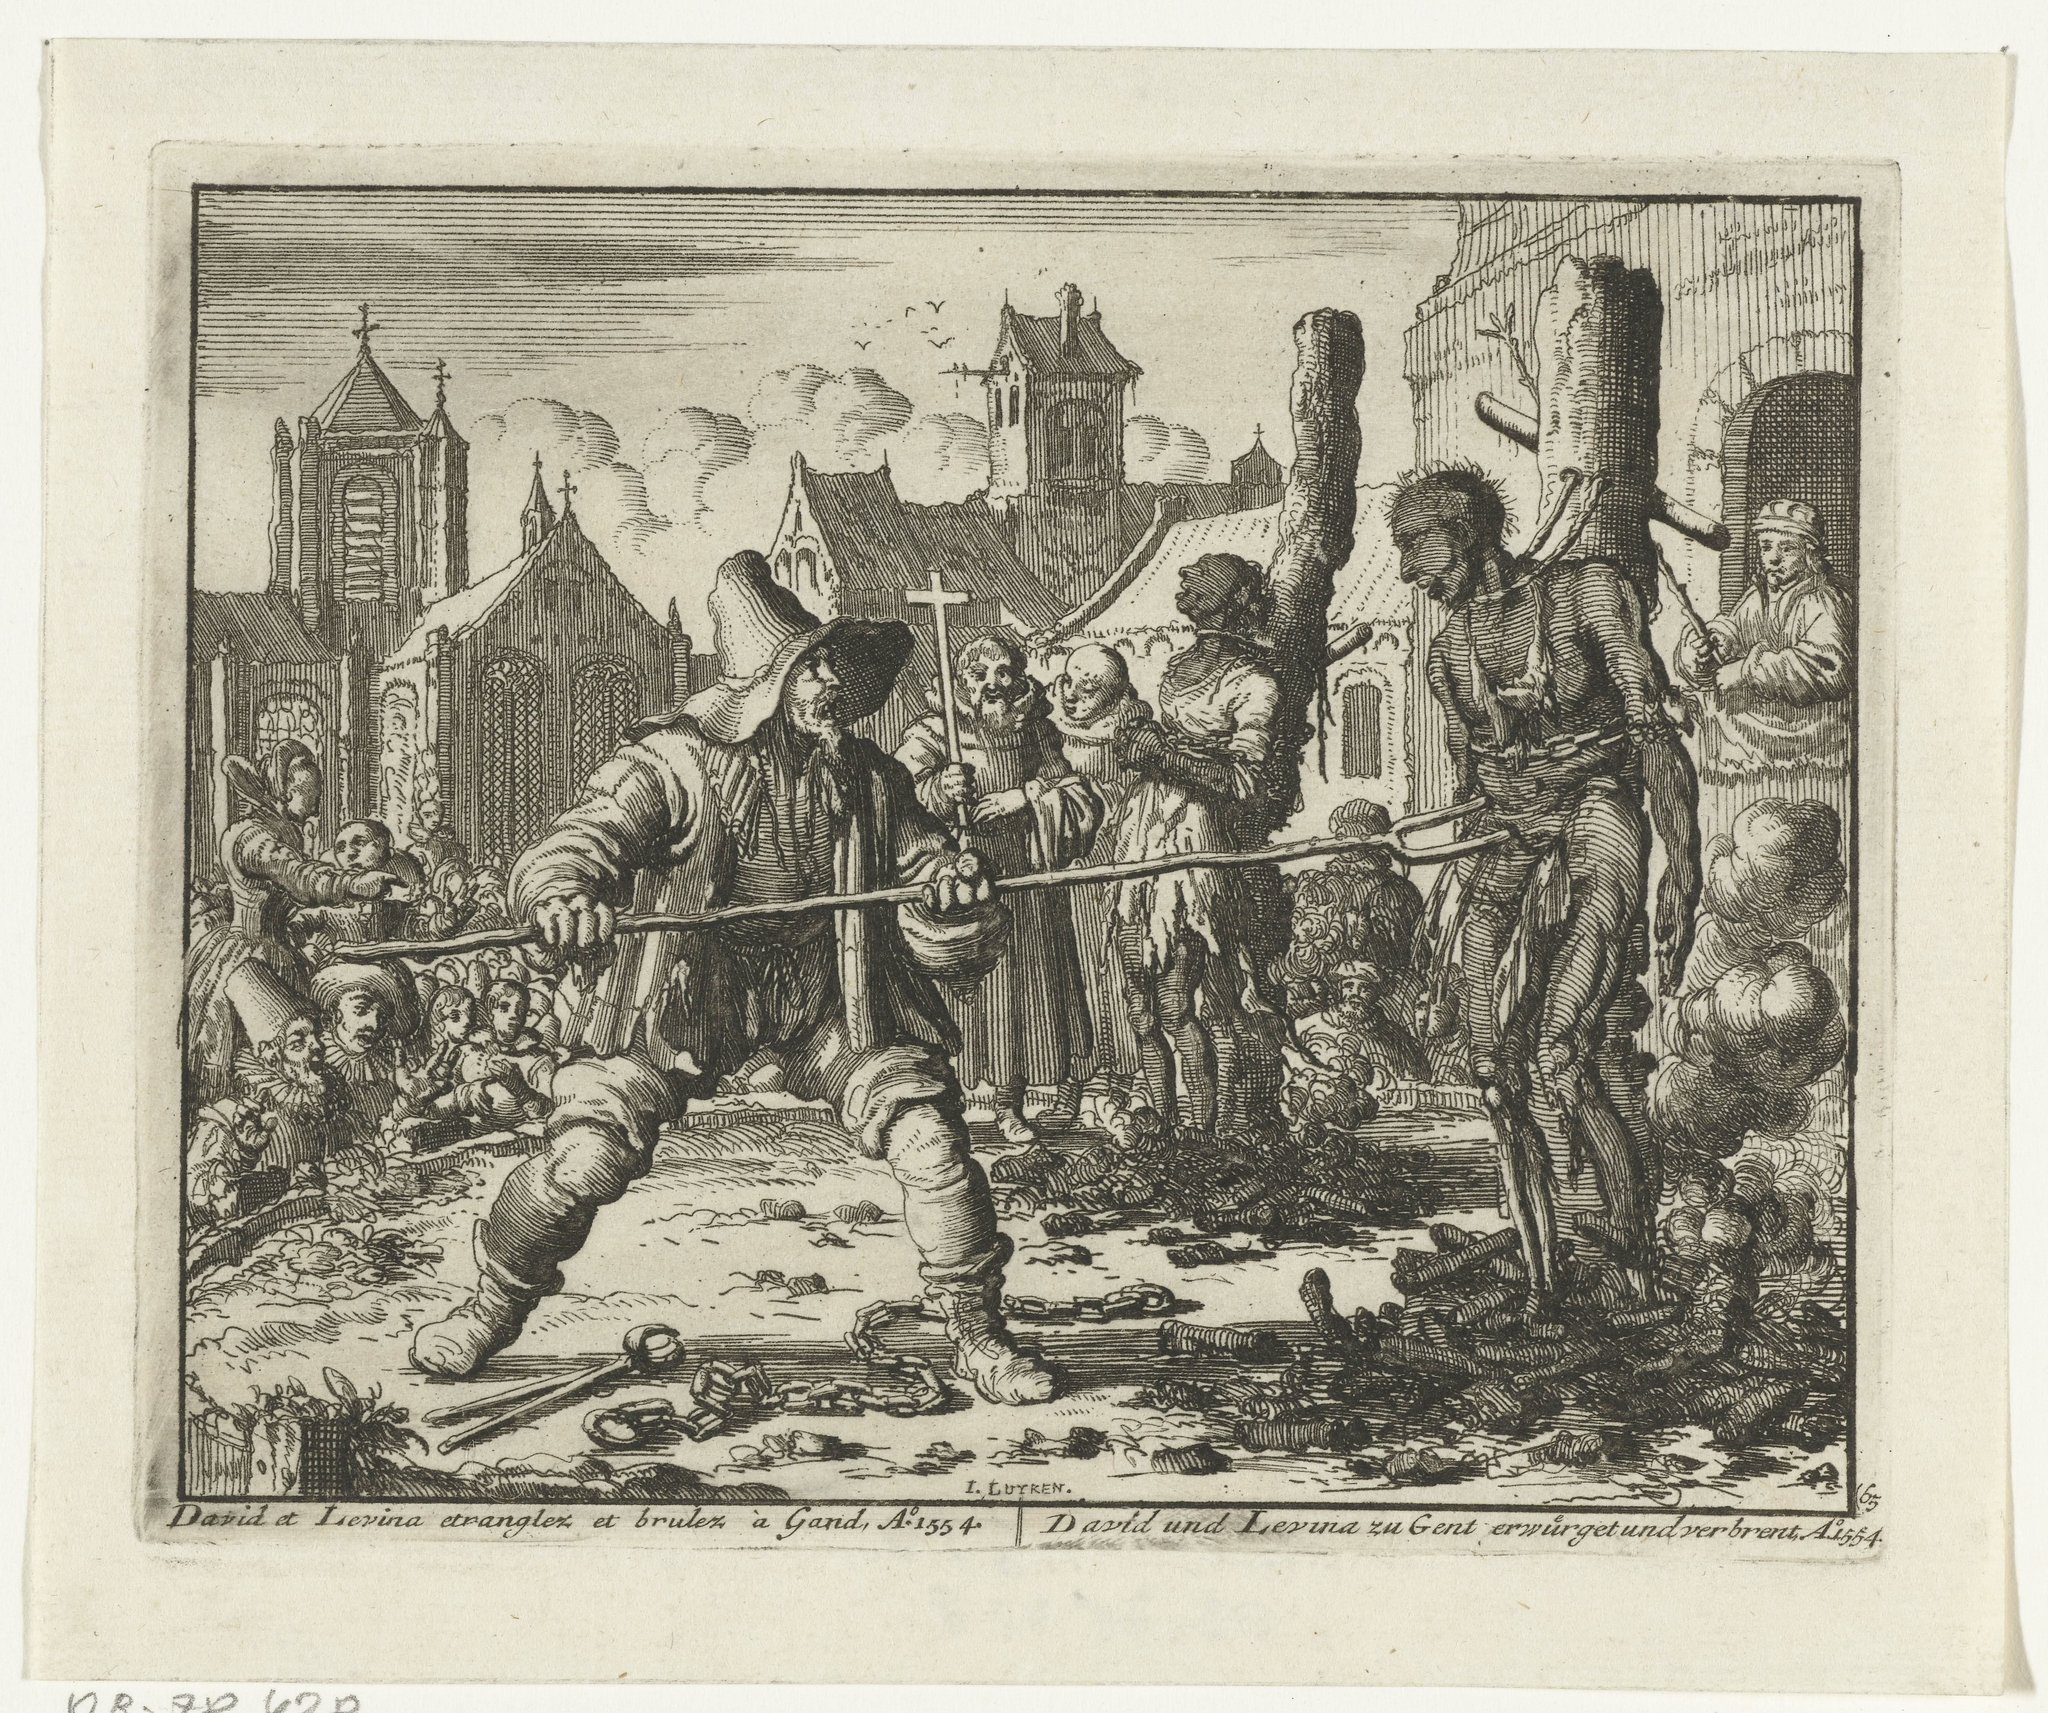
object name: history print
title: De verbrande lijken van David en Levina te Gent, 1554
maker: jan luyken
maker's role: draughtsman, print maker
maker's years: 1649-1712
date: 1683-1685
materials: paper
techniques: etching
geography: northern netherlands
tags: violent death by burning at the stake; pyre, persecution of heretics, ghent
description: De prenten in deze tweede staat gebruikt als illustratie voor: Theatre des martyrs, depuis la mort de J. Christ jusqu'à present (...). = Schau-buhne der Martyrer, P. van der Aa, Leiden ca. 1715, nr. 65. De prenten zijn oorspronkelijk vervaardigd voor en eerst gebruikt in: T.J. van Bragt, Het bloedig tooneel, of Martelaers spiegel der doops-gesinde of weereloose christenen, 1685.